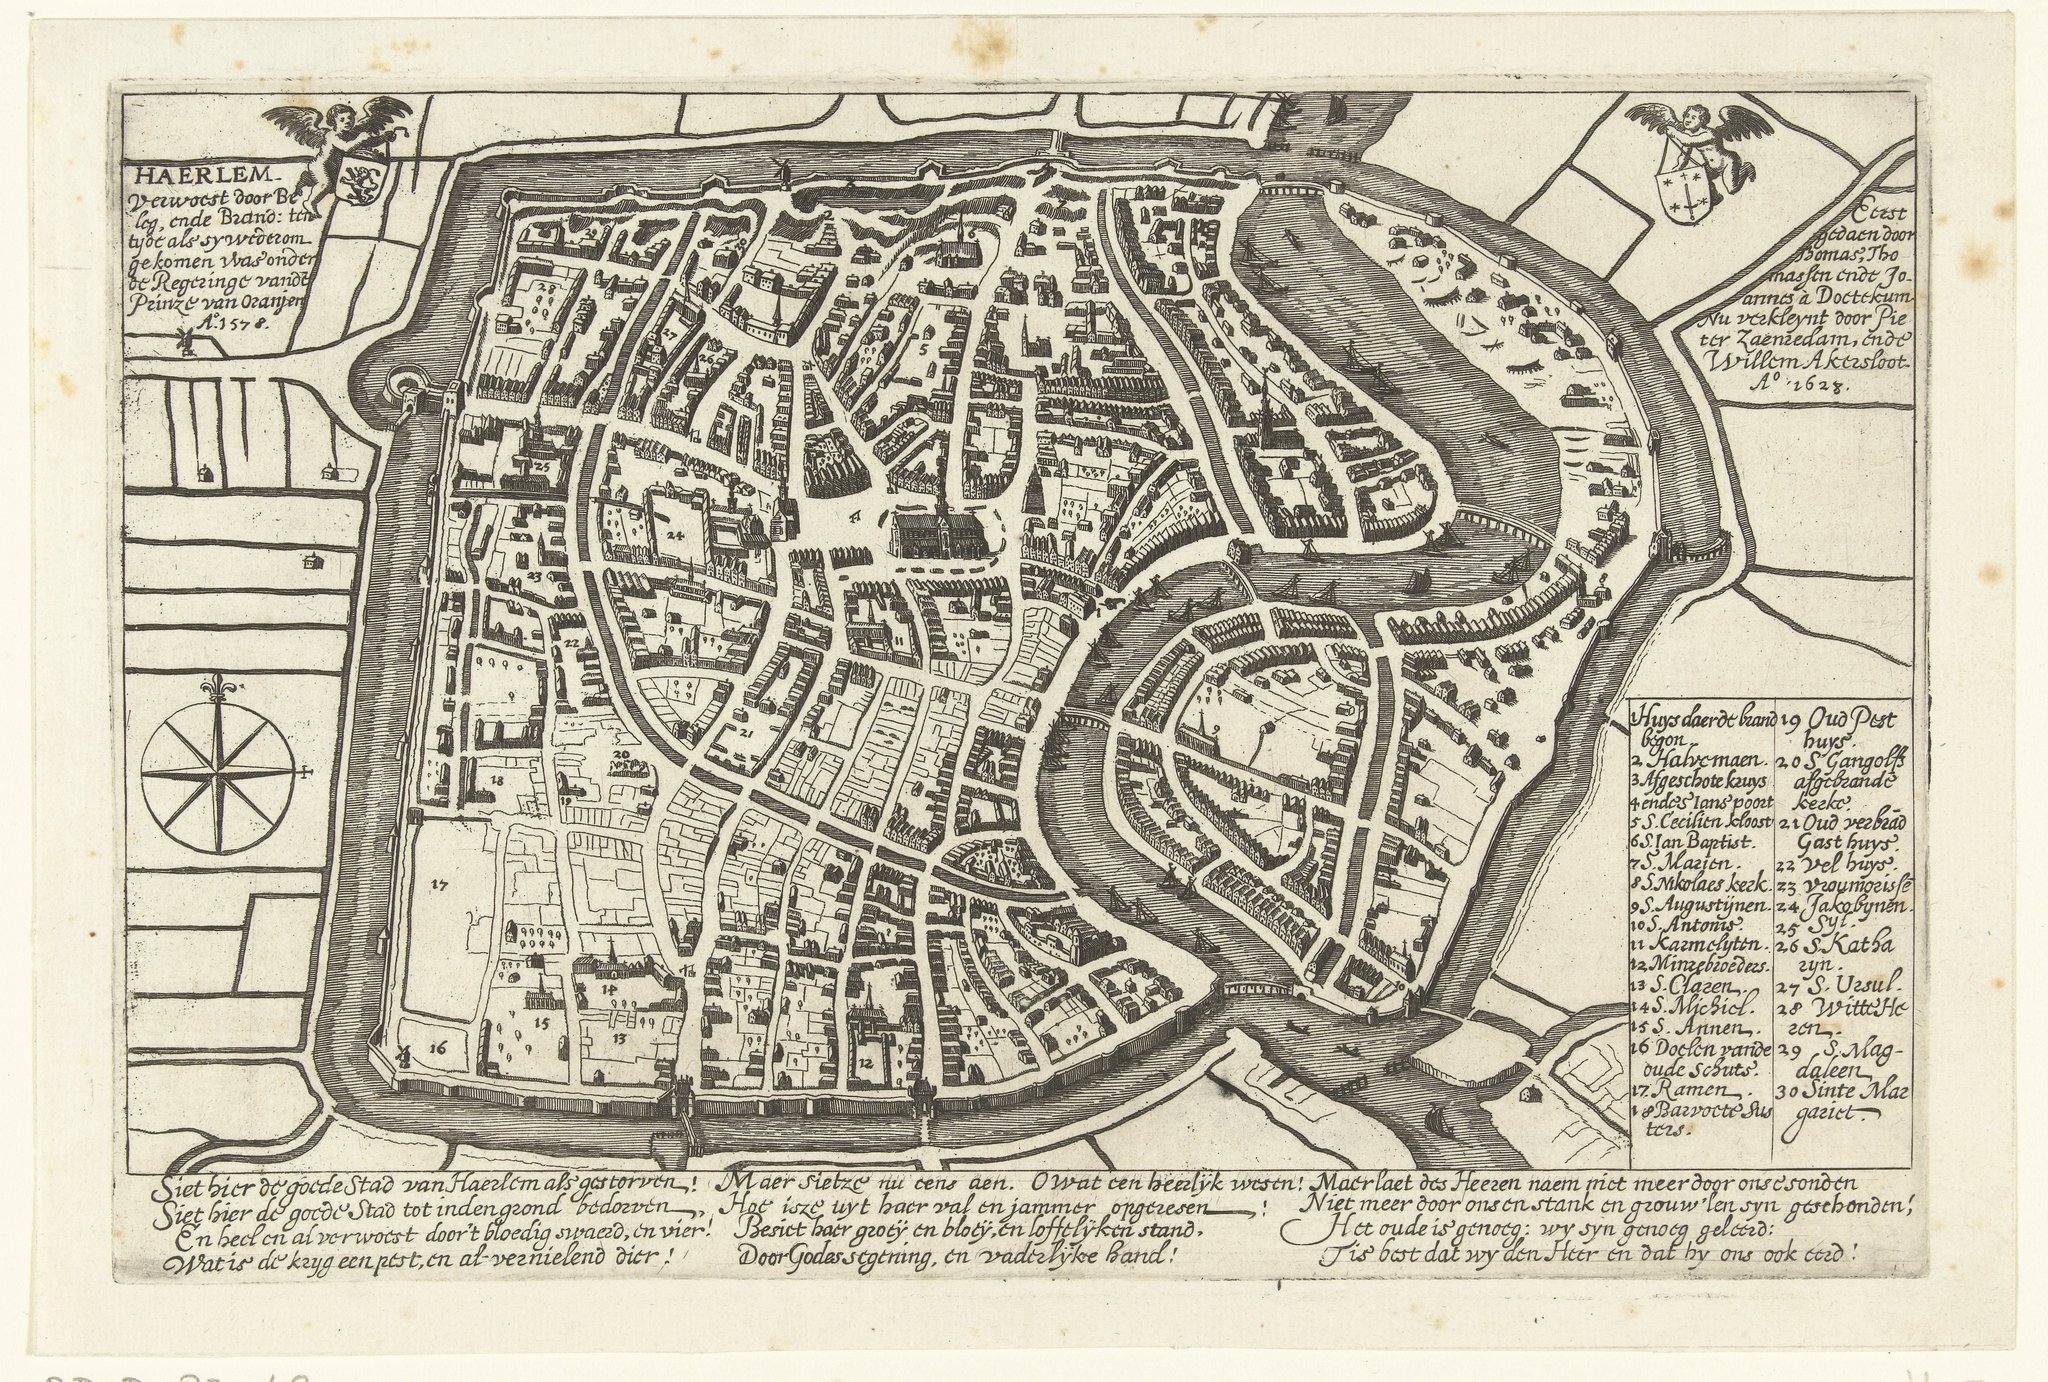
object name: book illustration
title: Haerlem verwoest door beleg, ende brand: ten tydt als sy wederom gekomen was onder de regeringe vande Prinze van Oranjen Ao. 1578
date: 1628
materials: paper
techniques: engraving, etching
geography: haarlem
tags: on fire, ablaze, maps of cities, haarlem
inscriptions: collector's mark: Lugt 240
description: Plattegrond van Haarlem met de verwoestingen in de stad na het beleg en de grote brand van 1576. Met onderschrift van drie verzen van elk vier regels in het Nederlands: Siet hier de goede Stad van Haerlem als gestorven [...]. Rechtsonder de legenda 1-30.